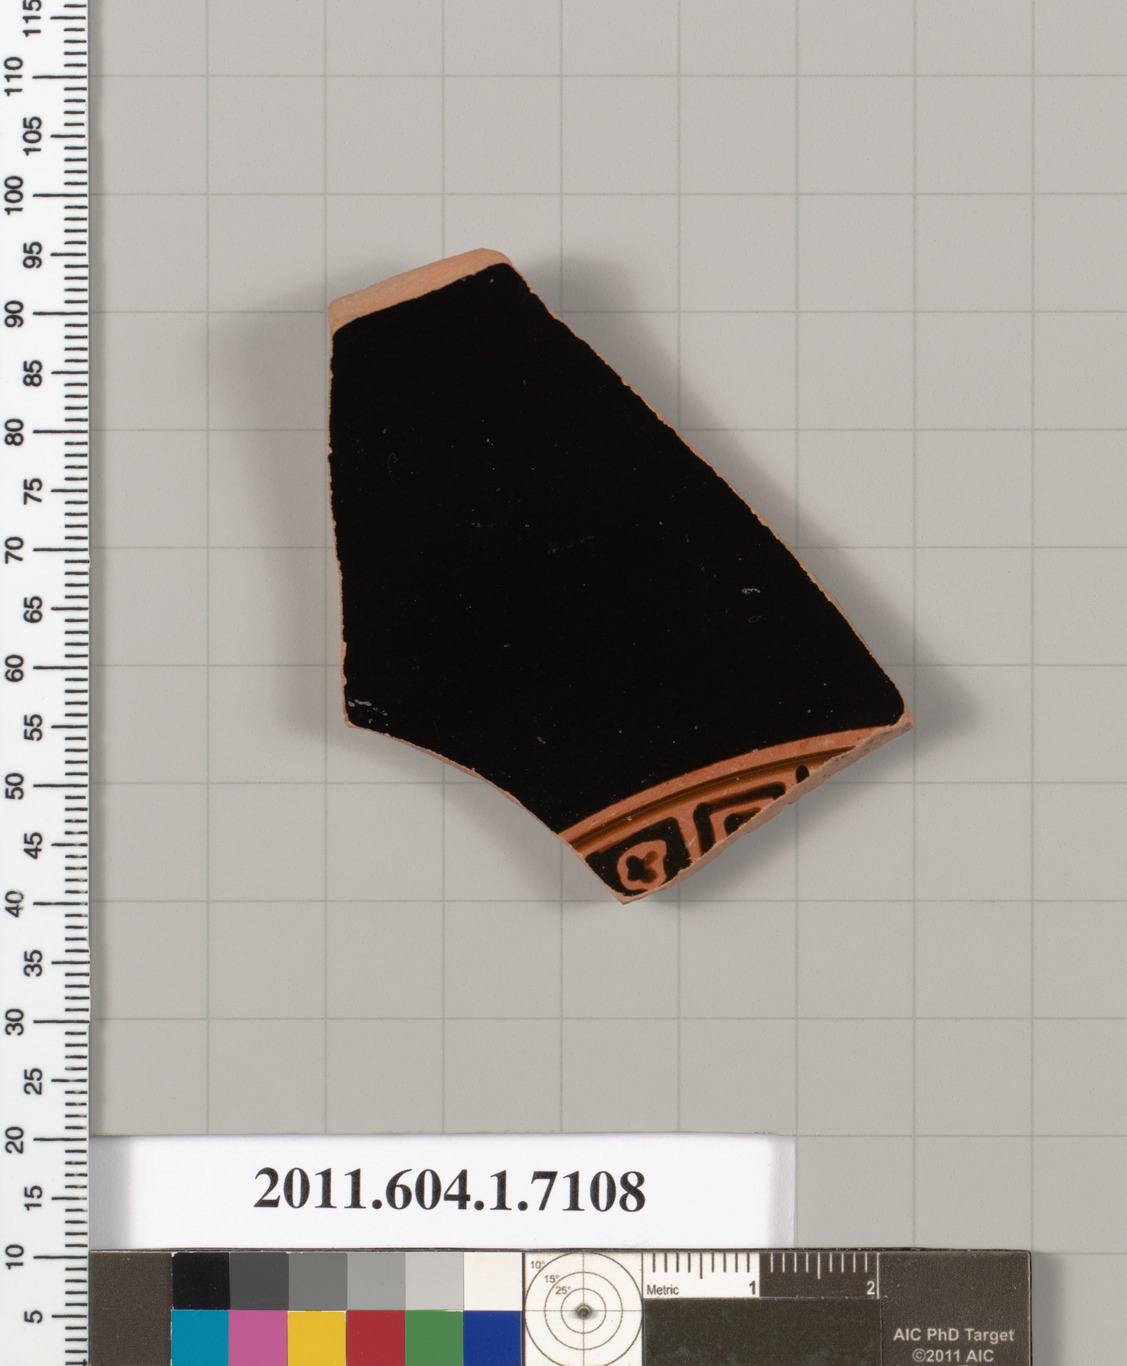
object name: kylix fragment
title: Terracotta fragment of a kylix (drinking cup)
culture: greek, attic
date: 500-480 BCE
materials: terracotta